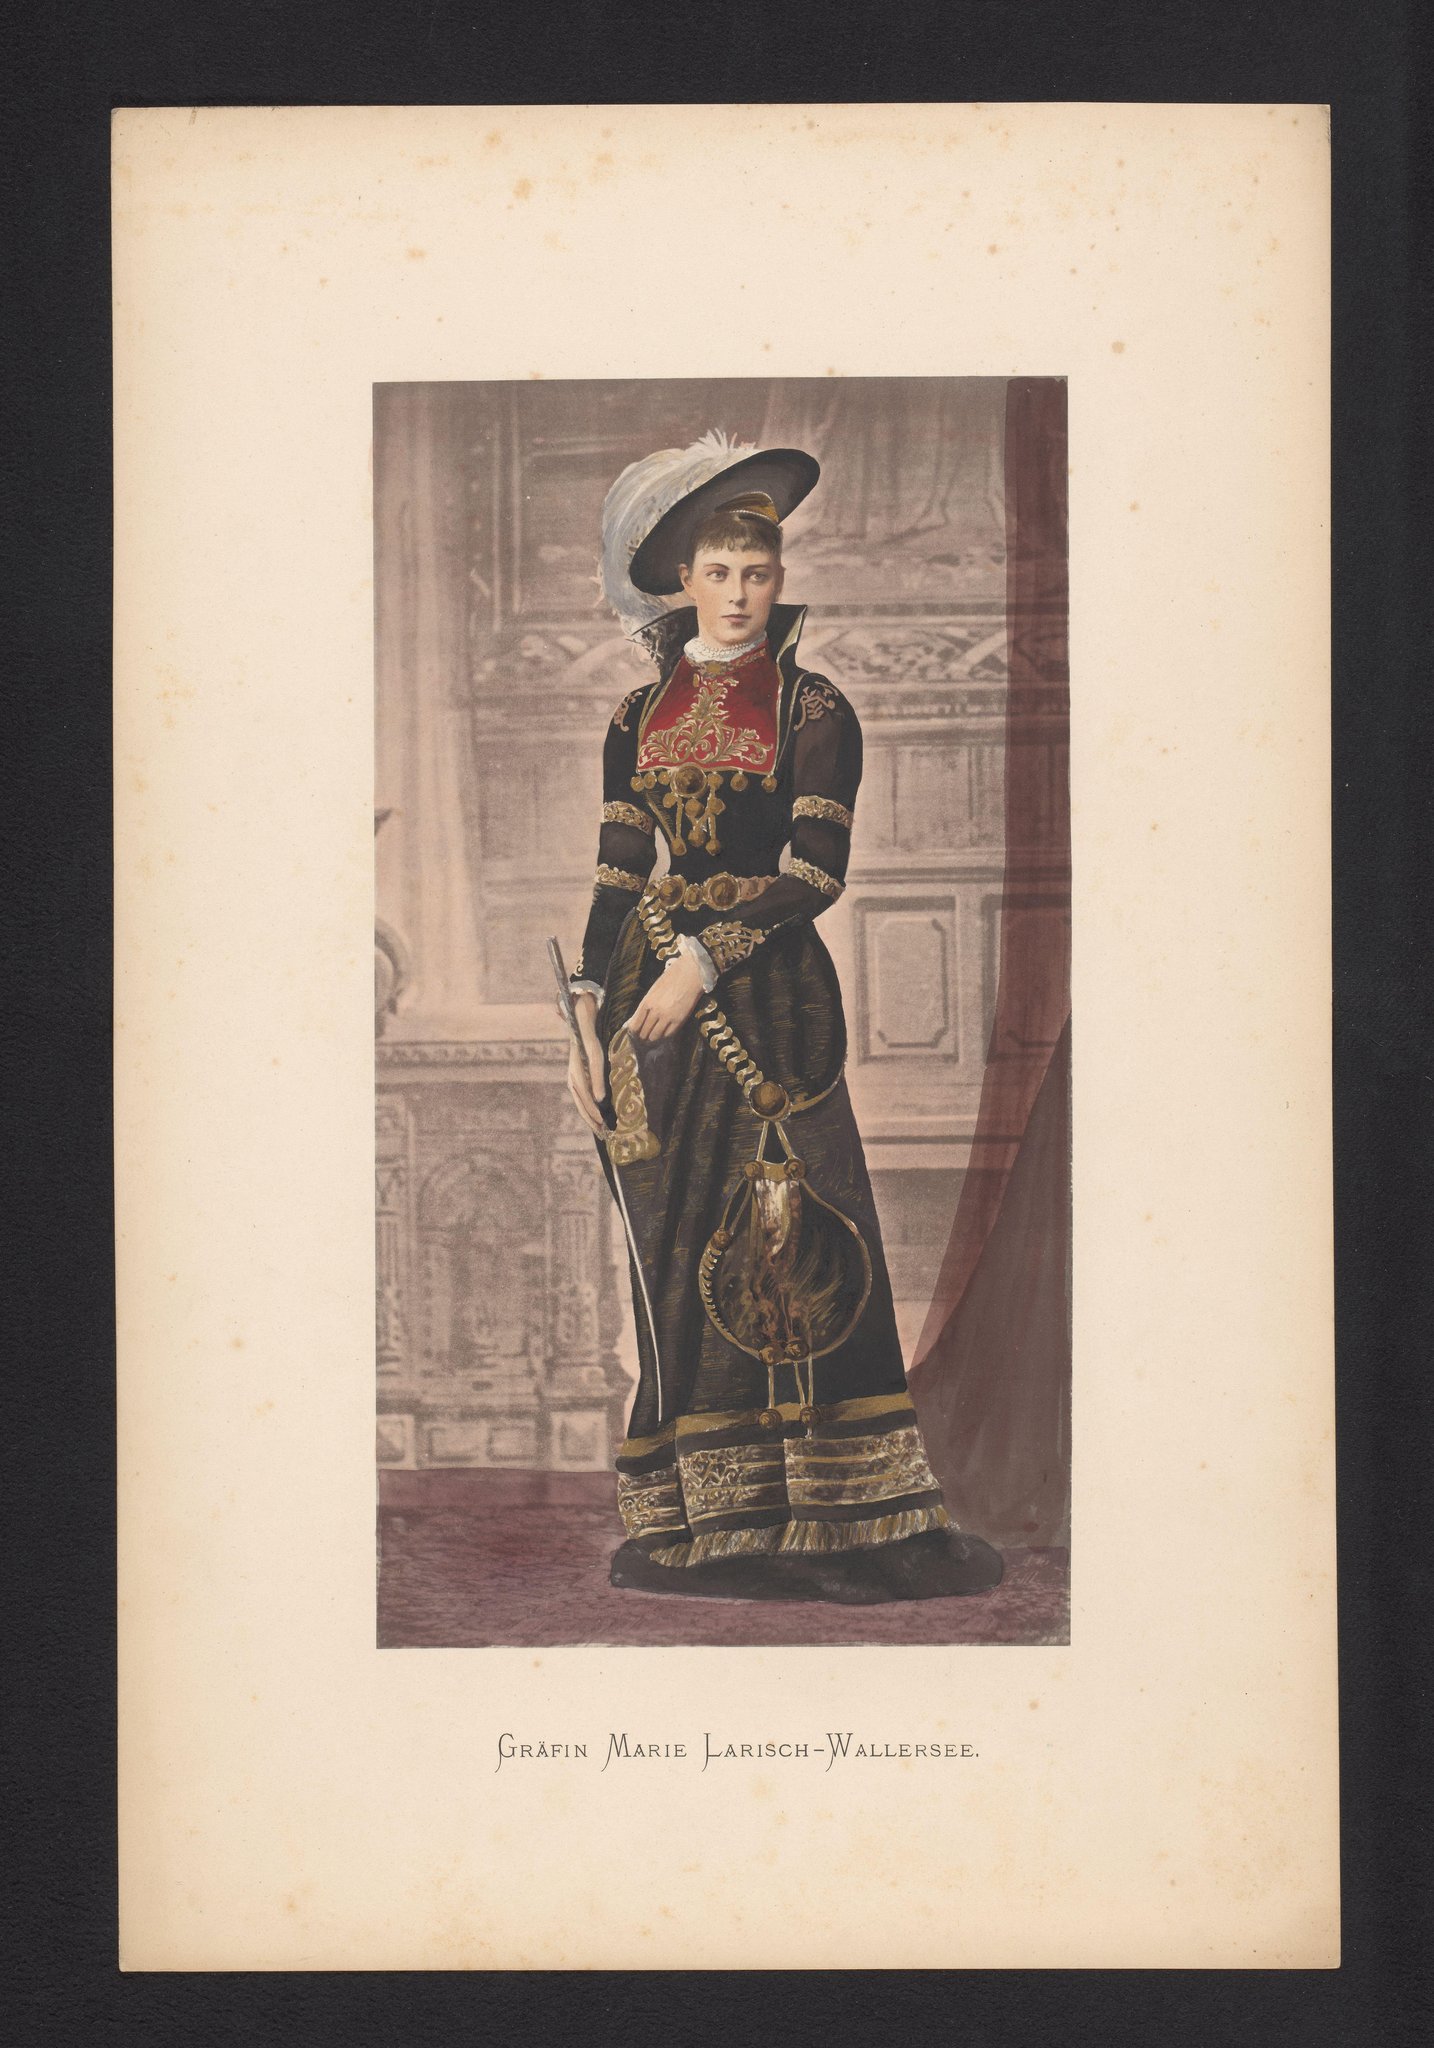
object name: photomechanical print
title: Gräfin Marie Larisch-Wallersee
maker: Anonymous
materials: paper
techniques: photograph, hand coloring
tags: augsburg, historical persons - bb - woman, aristocracy; 'aristocratia' (ripa)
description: Deze prent maakt deel uit van een omslag met 86 prenten op 78 bladen en 11 tekstbladen.